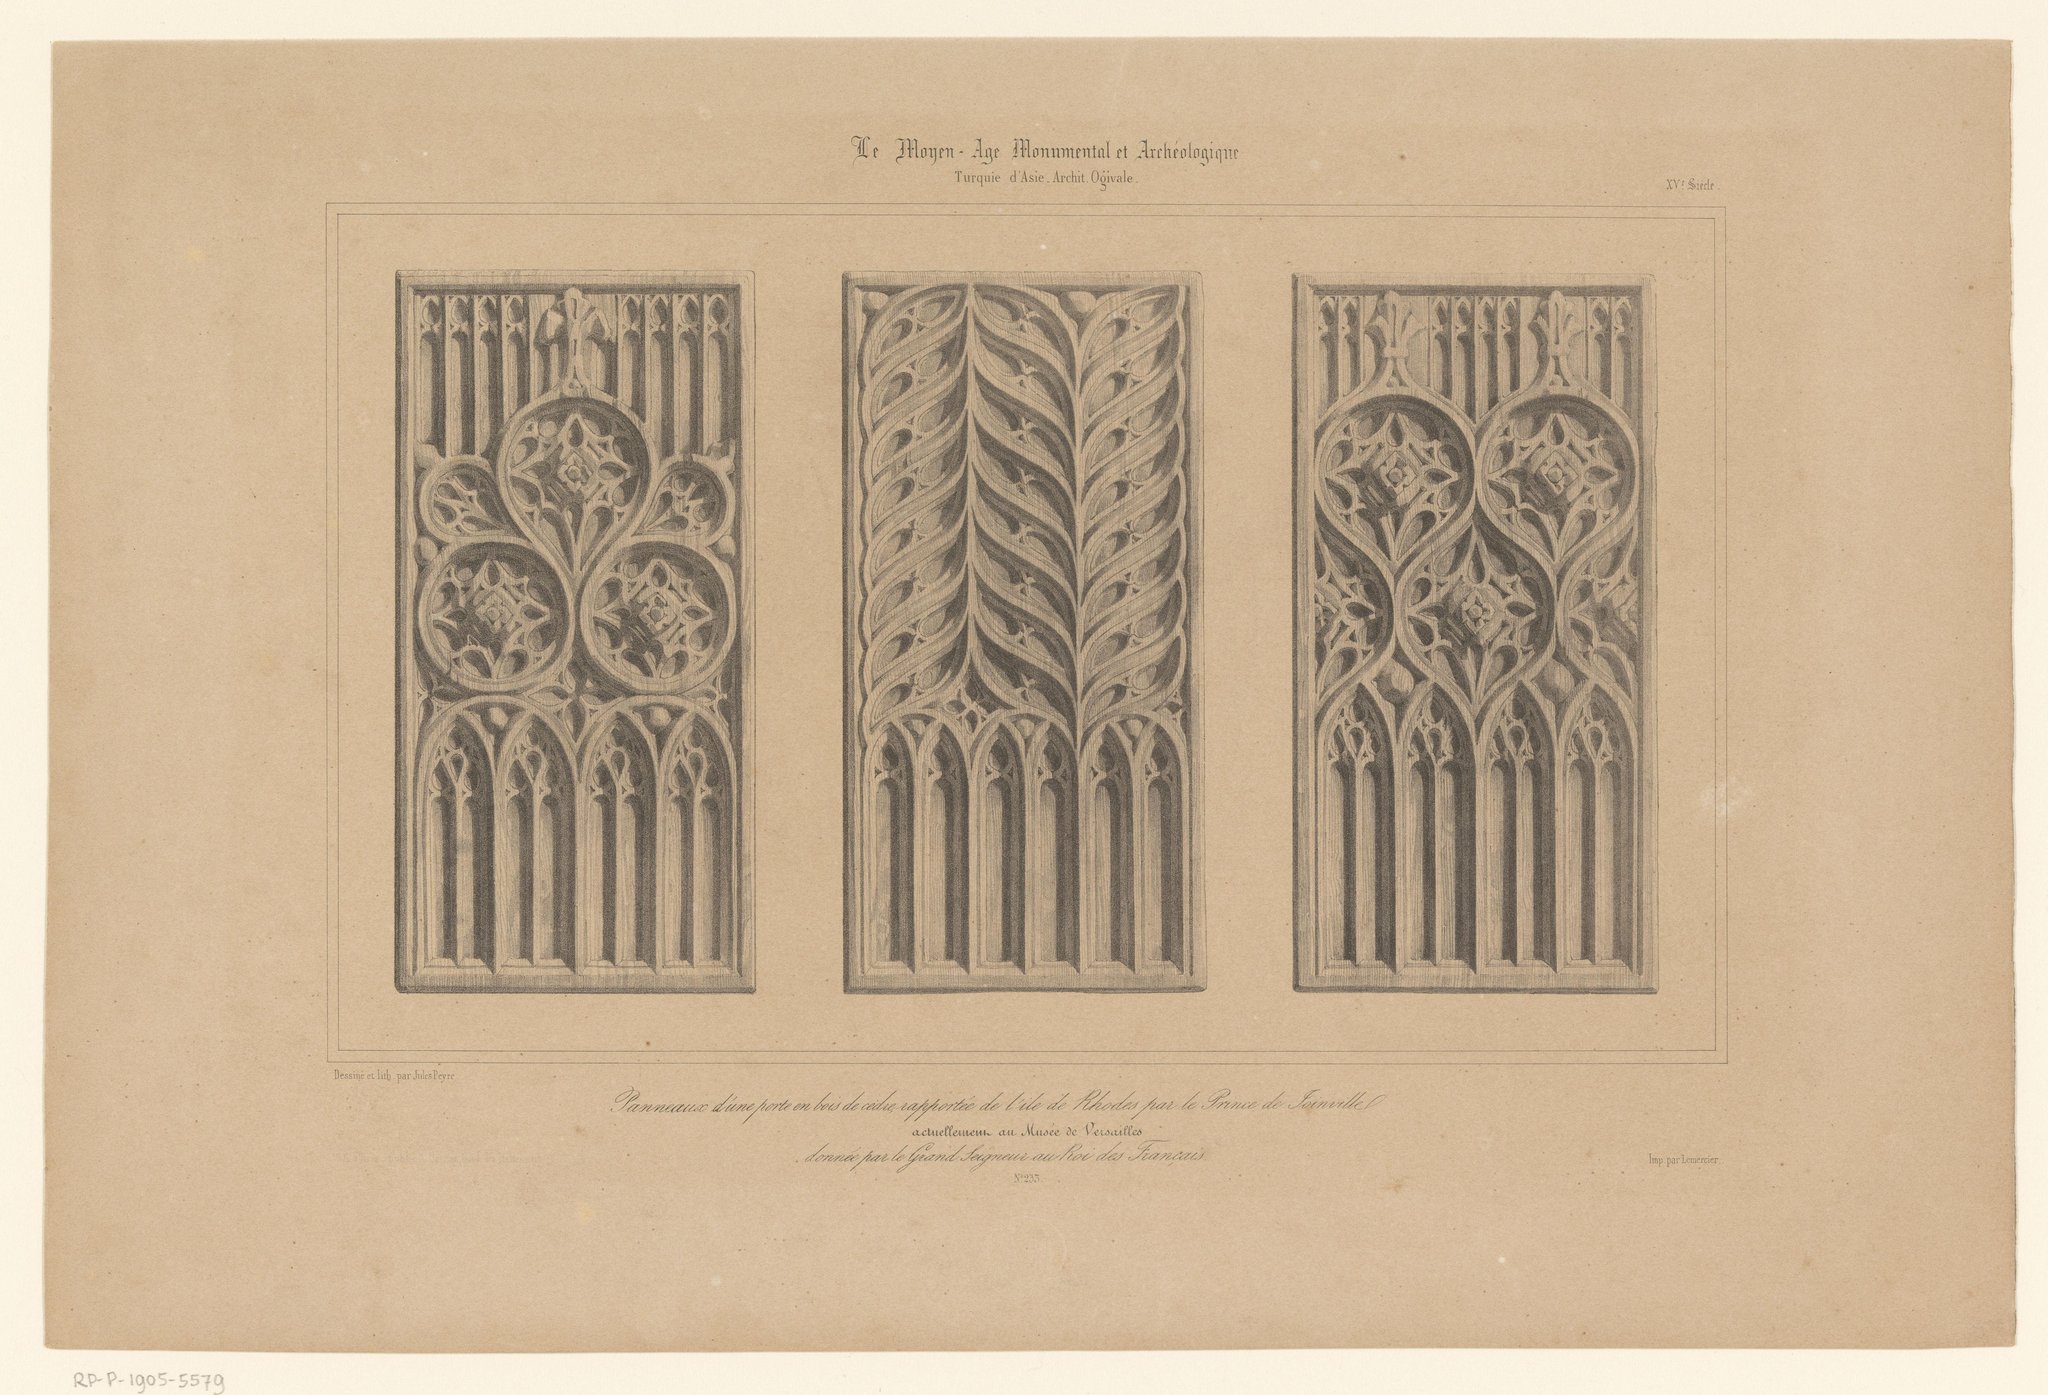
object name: print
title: Le Moyen-Age monumental et archéologique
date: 1840-1851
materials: paper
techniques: lithograph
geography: paris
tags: art (+ wood, e.g.: panel ~ arts), door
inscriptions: check stamp: Lugt 4210, collector's mark: Lugt 2228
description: Deze serie bestaat uit in ieder geval 431 en mogelijk meer prenten. De serie werd in verschillende 'livraisons' uitgegeven tussen 1840 en 1851. Gebaseerd op vermeldingen in 'Bibliographie de la France' (via http://artfl-project.uchicago.edu/content/image-france).